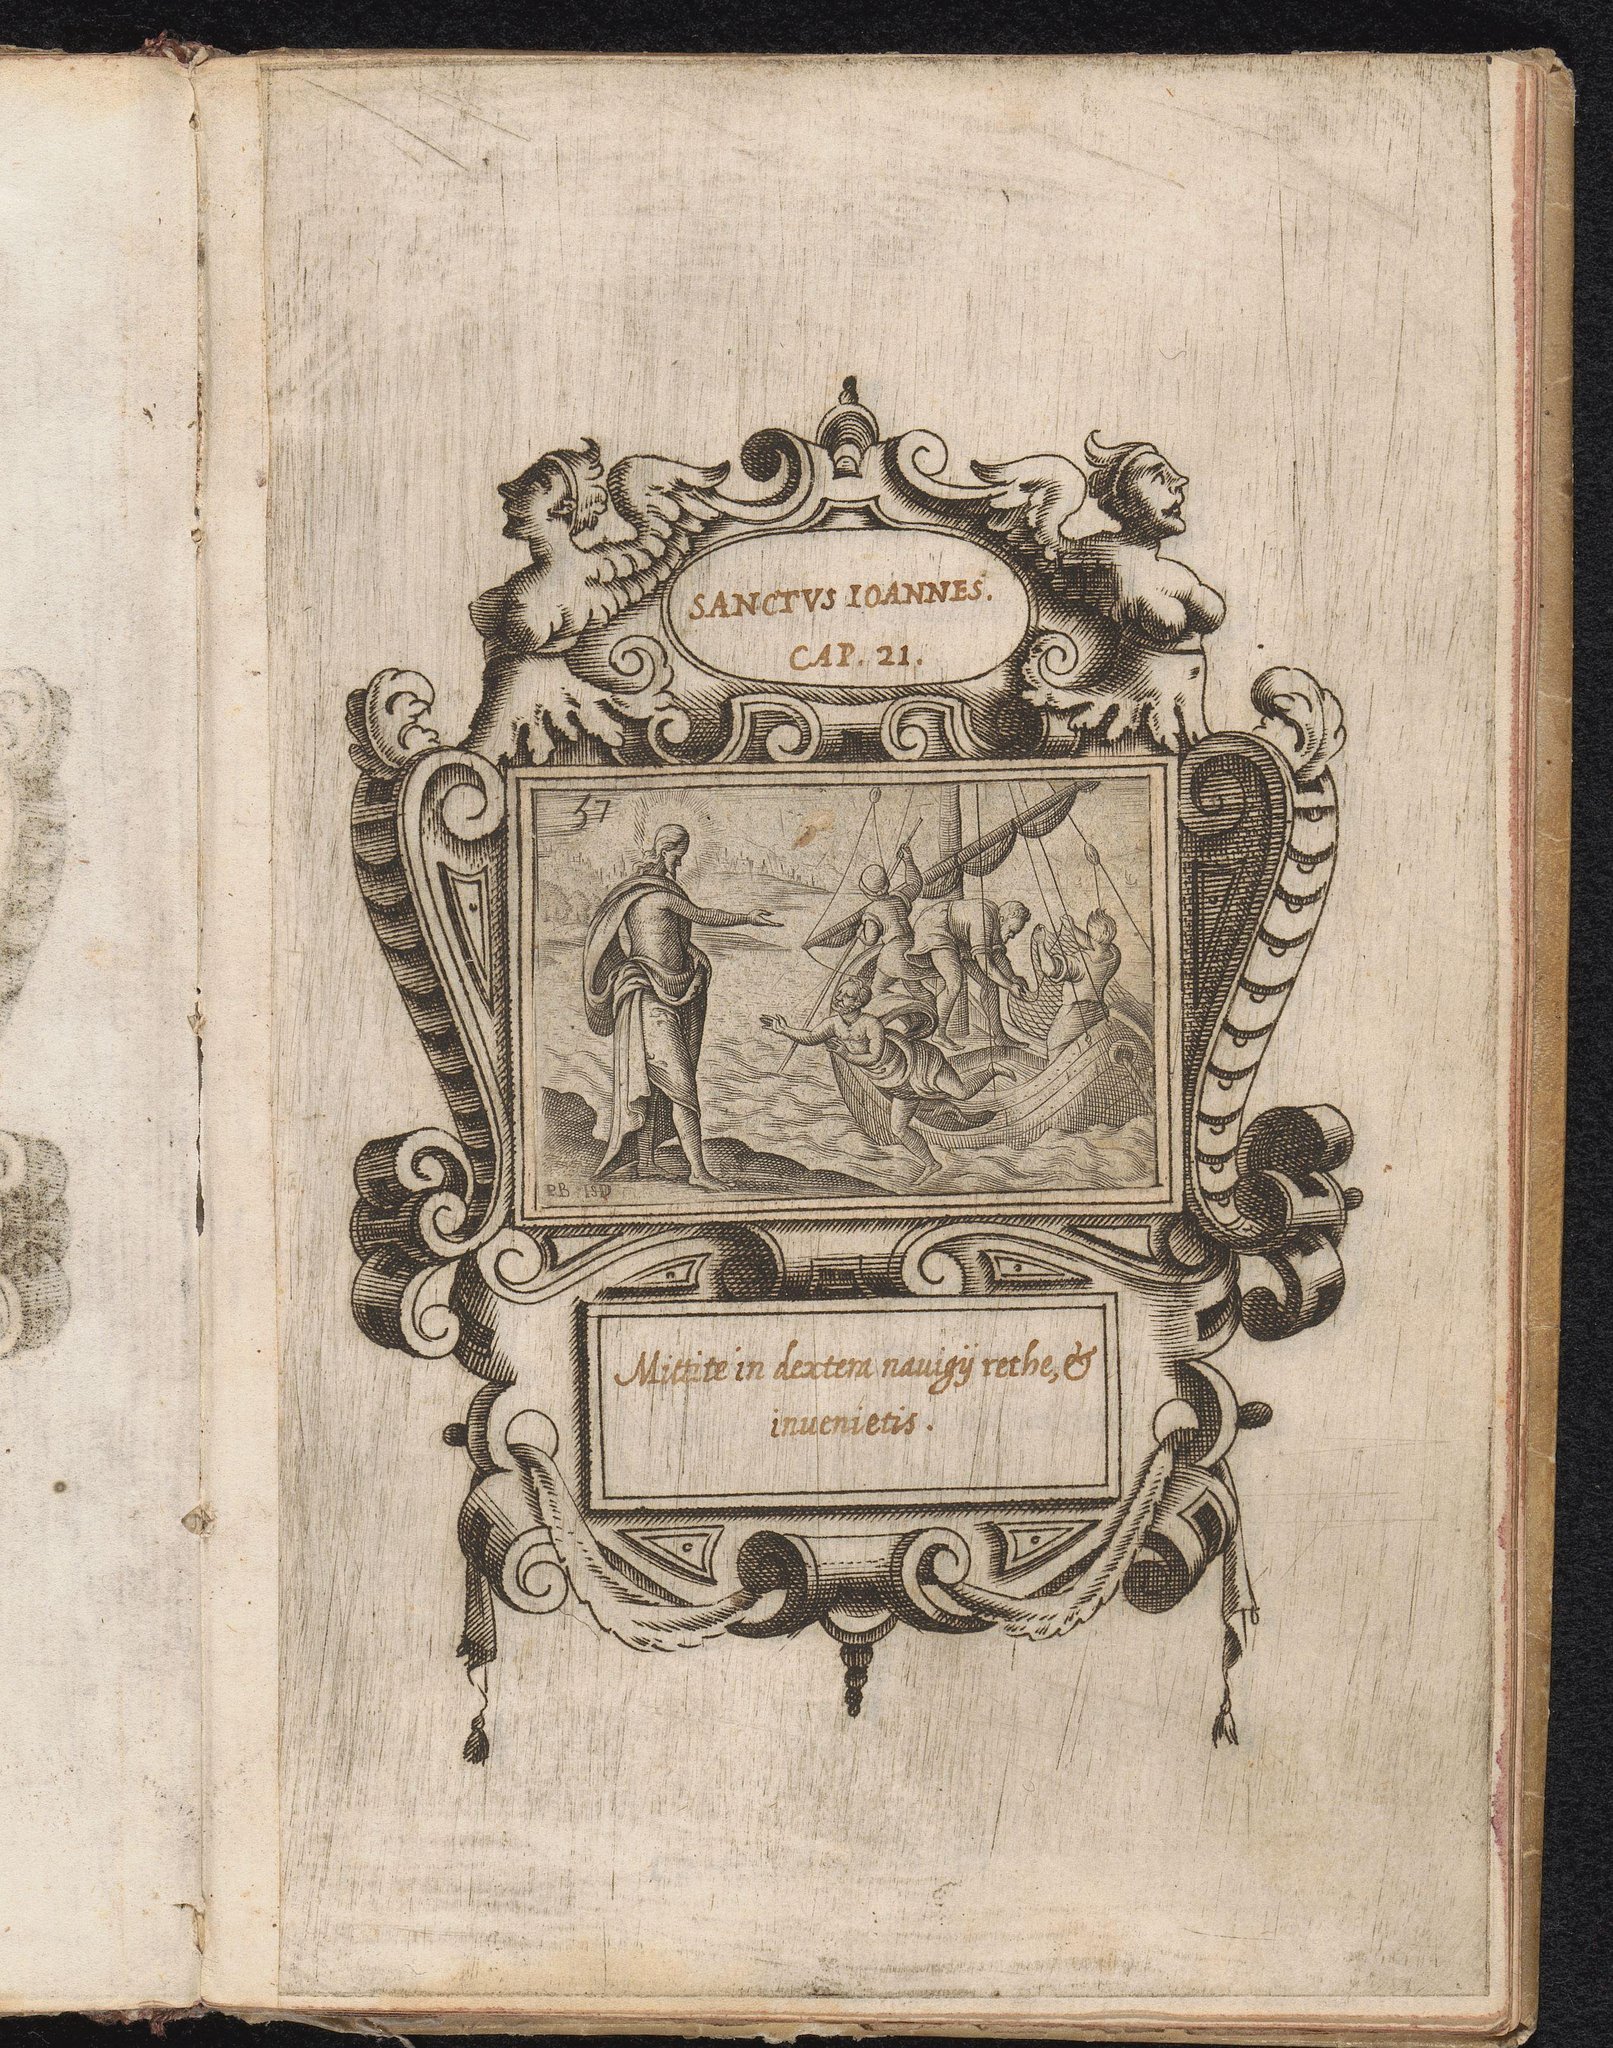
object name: print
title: Het leven van Christus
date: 1570-1610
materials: paper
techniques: engraving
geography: antwerp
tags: peter walking on the water towards christ on the shore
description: Petrus loopt op het water naar Christus. Onderdeel van een prentalbum met titelprent en 56 scènes uit het Nieuwe Testament. Elke voorstelling gemonteerd in een gravure met ornamentele cartouches waarin een venster is gesneden en voorzien van handgeschreven bijbelpassages.